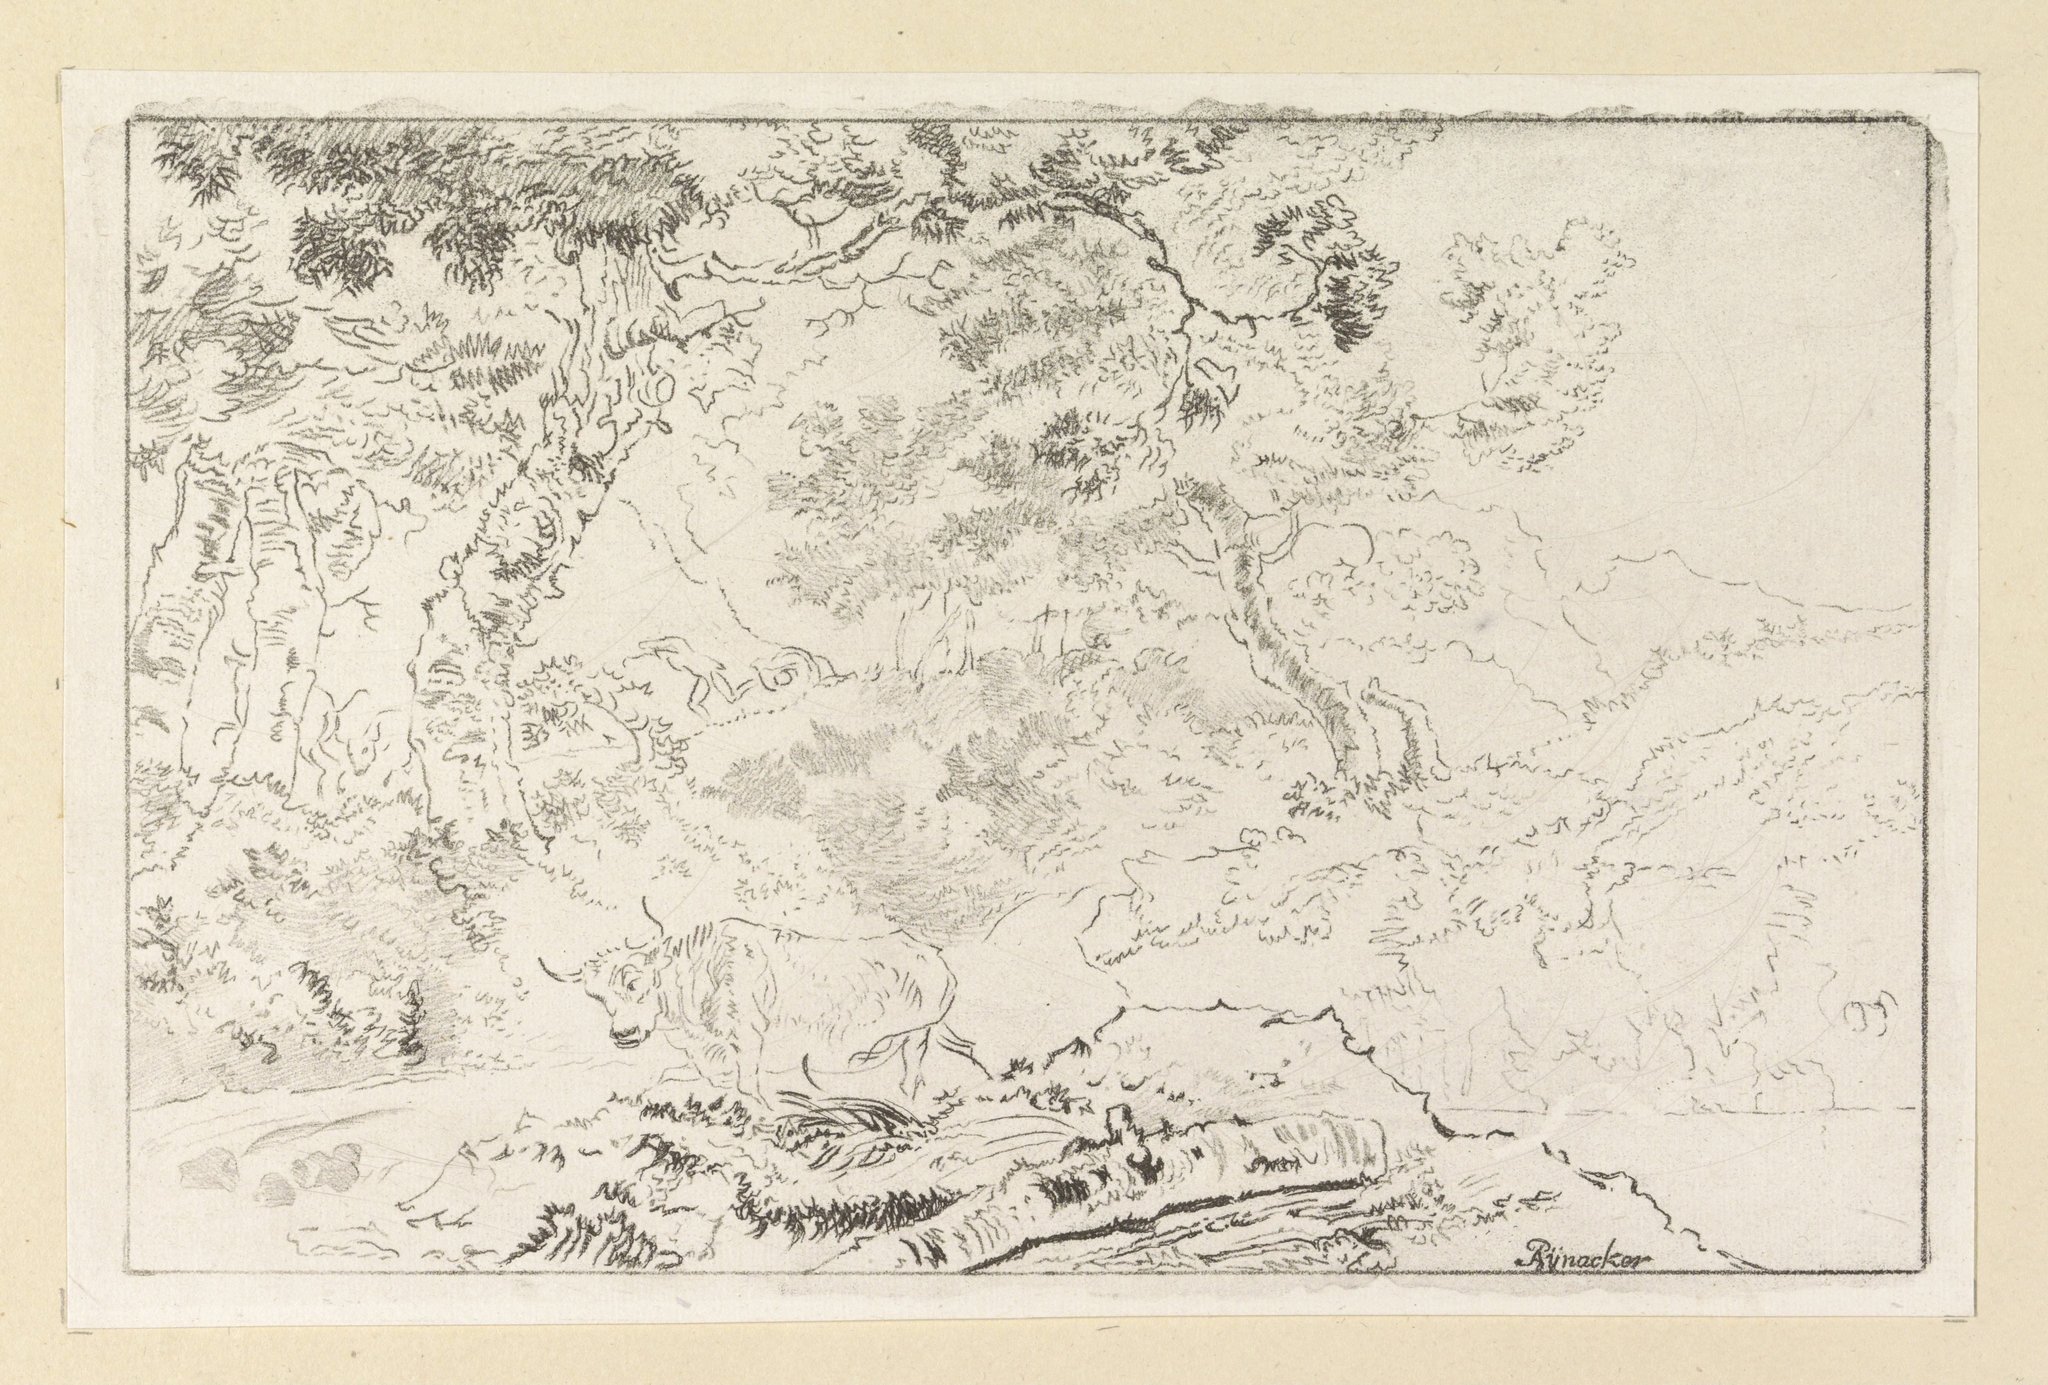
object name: print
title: Boslandschap met dier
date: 1795-1821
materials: paper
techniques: etching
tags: bull, landscapes (+ landscape with figures, staffage)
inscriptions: collector's mark: Lugt 2228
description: De voltooide prent werd opgenomen in: Collection d'imitations de dessins d'après les principaux maîtres hollandais et flamands, Londen, C. Josi, 1821.